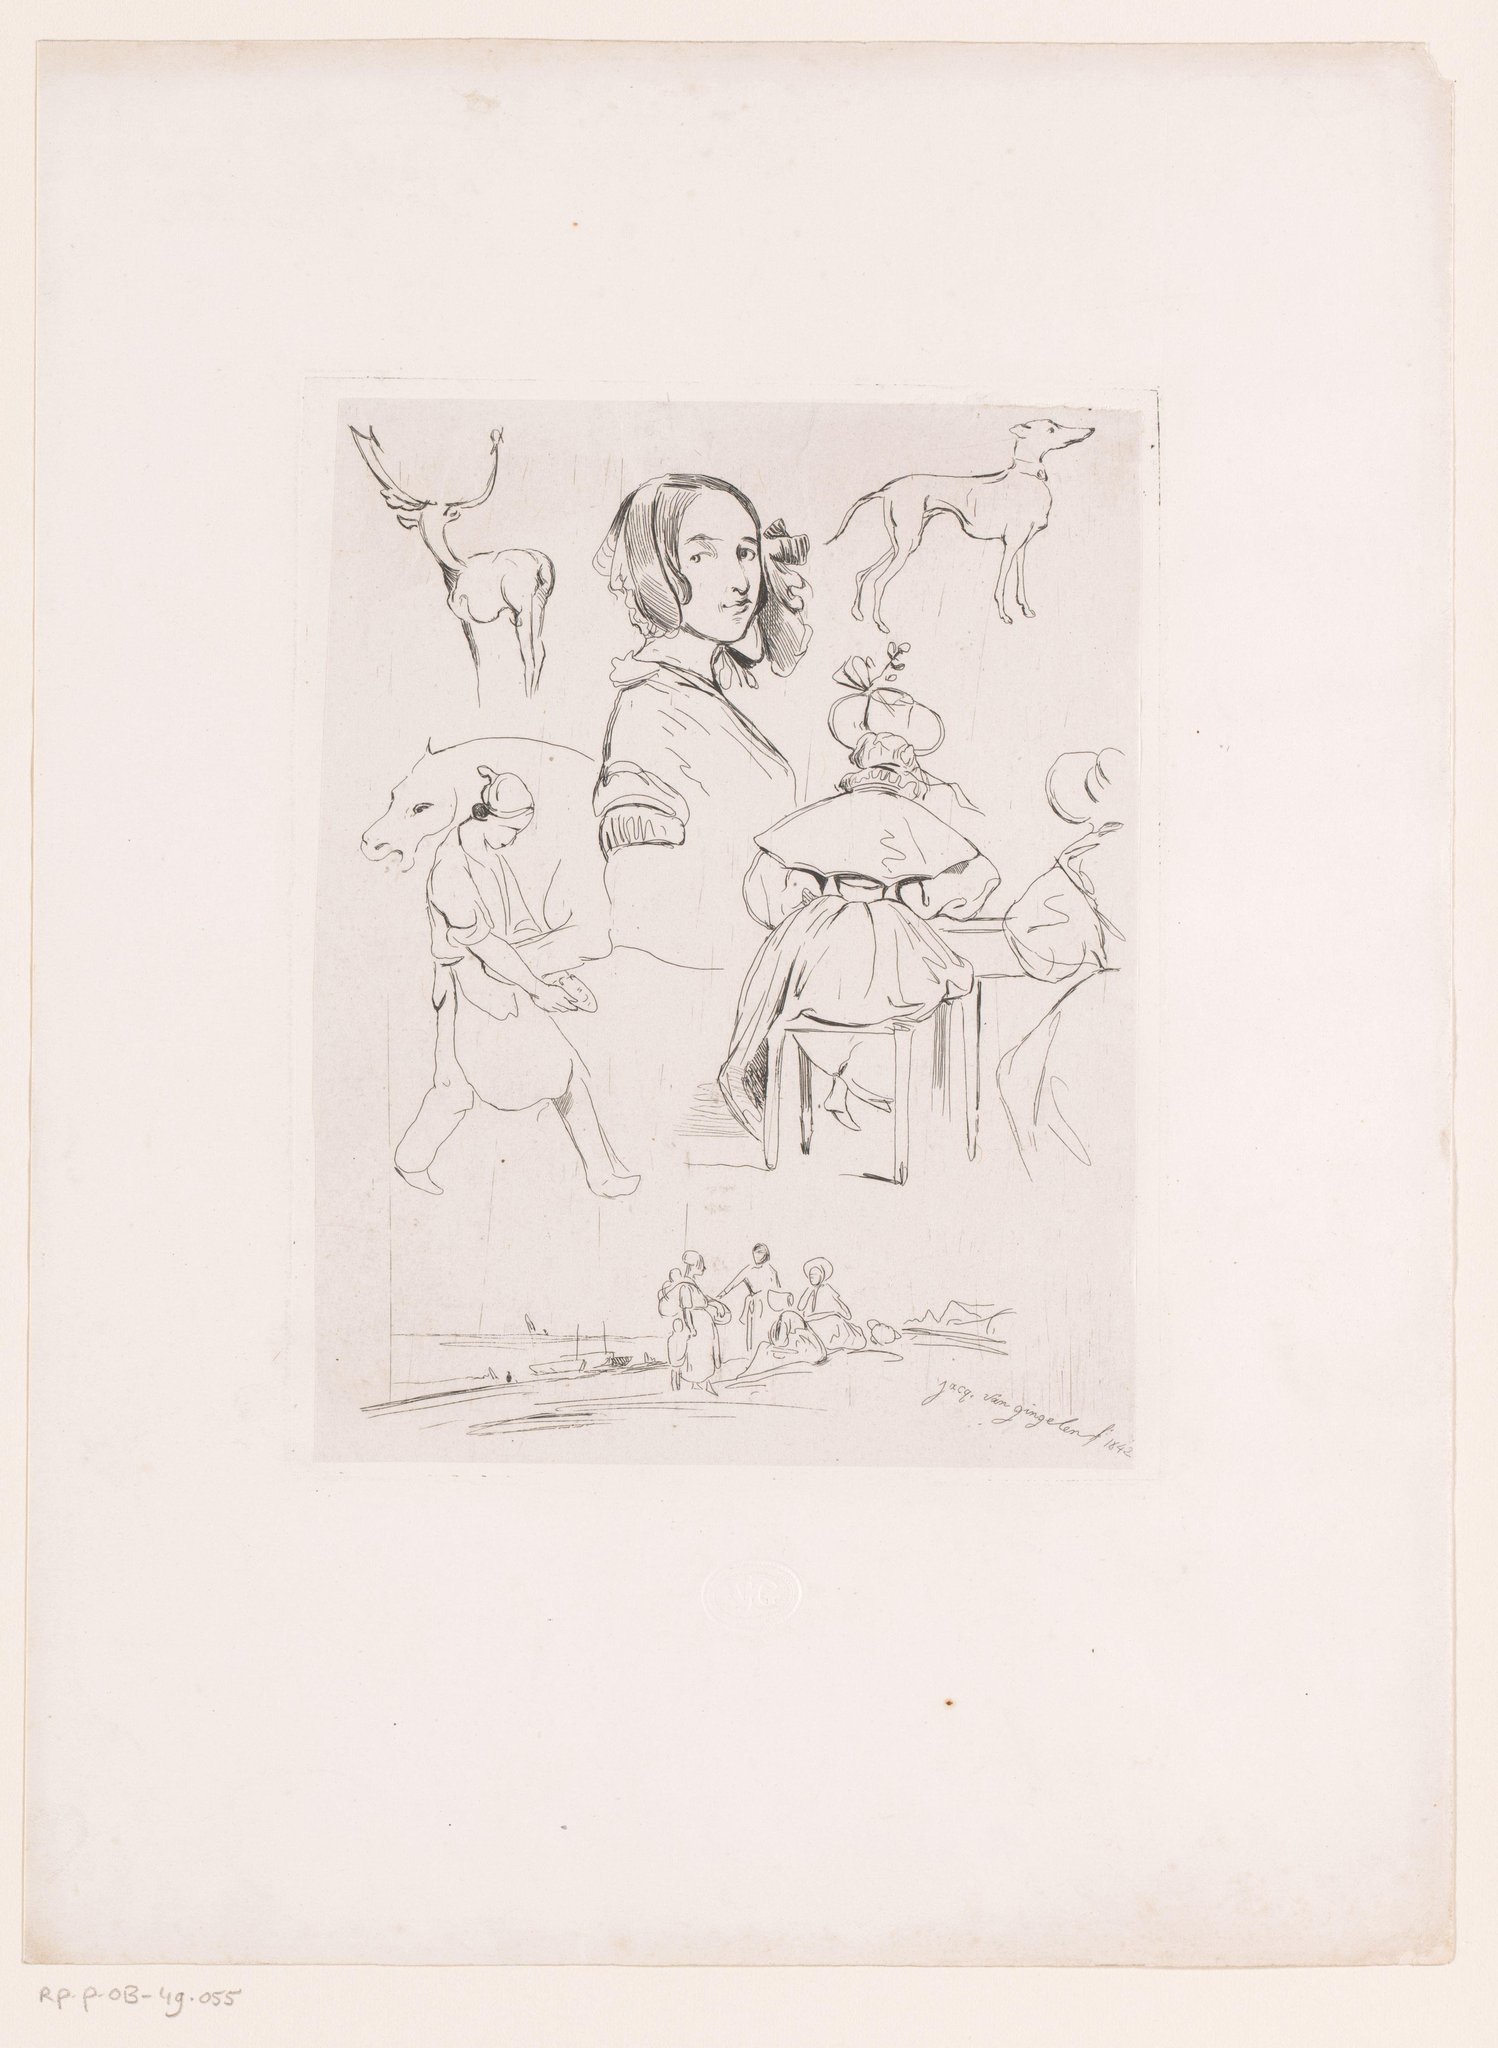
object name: print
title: Studie van onder andere vrouwen, een hoefsmid, een hert en een hond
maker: jacques van gingelen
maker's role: print maker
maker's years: 1801-1864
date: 1842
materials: paper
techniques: etching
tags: hoofed animals: deer, farrier, shoeing-smith, adolescent, young woman, maiden (+ seven persons), dog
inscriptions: mark: ‘JVG’, collector's mark: Lugt 2228